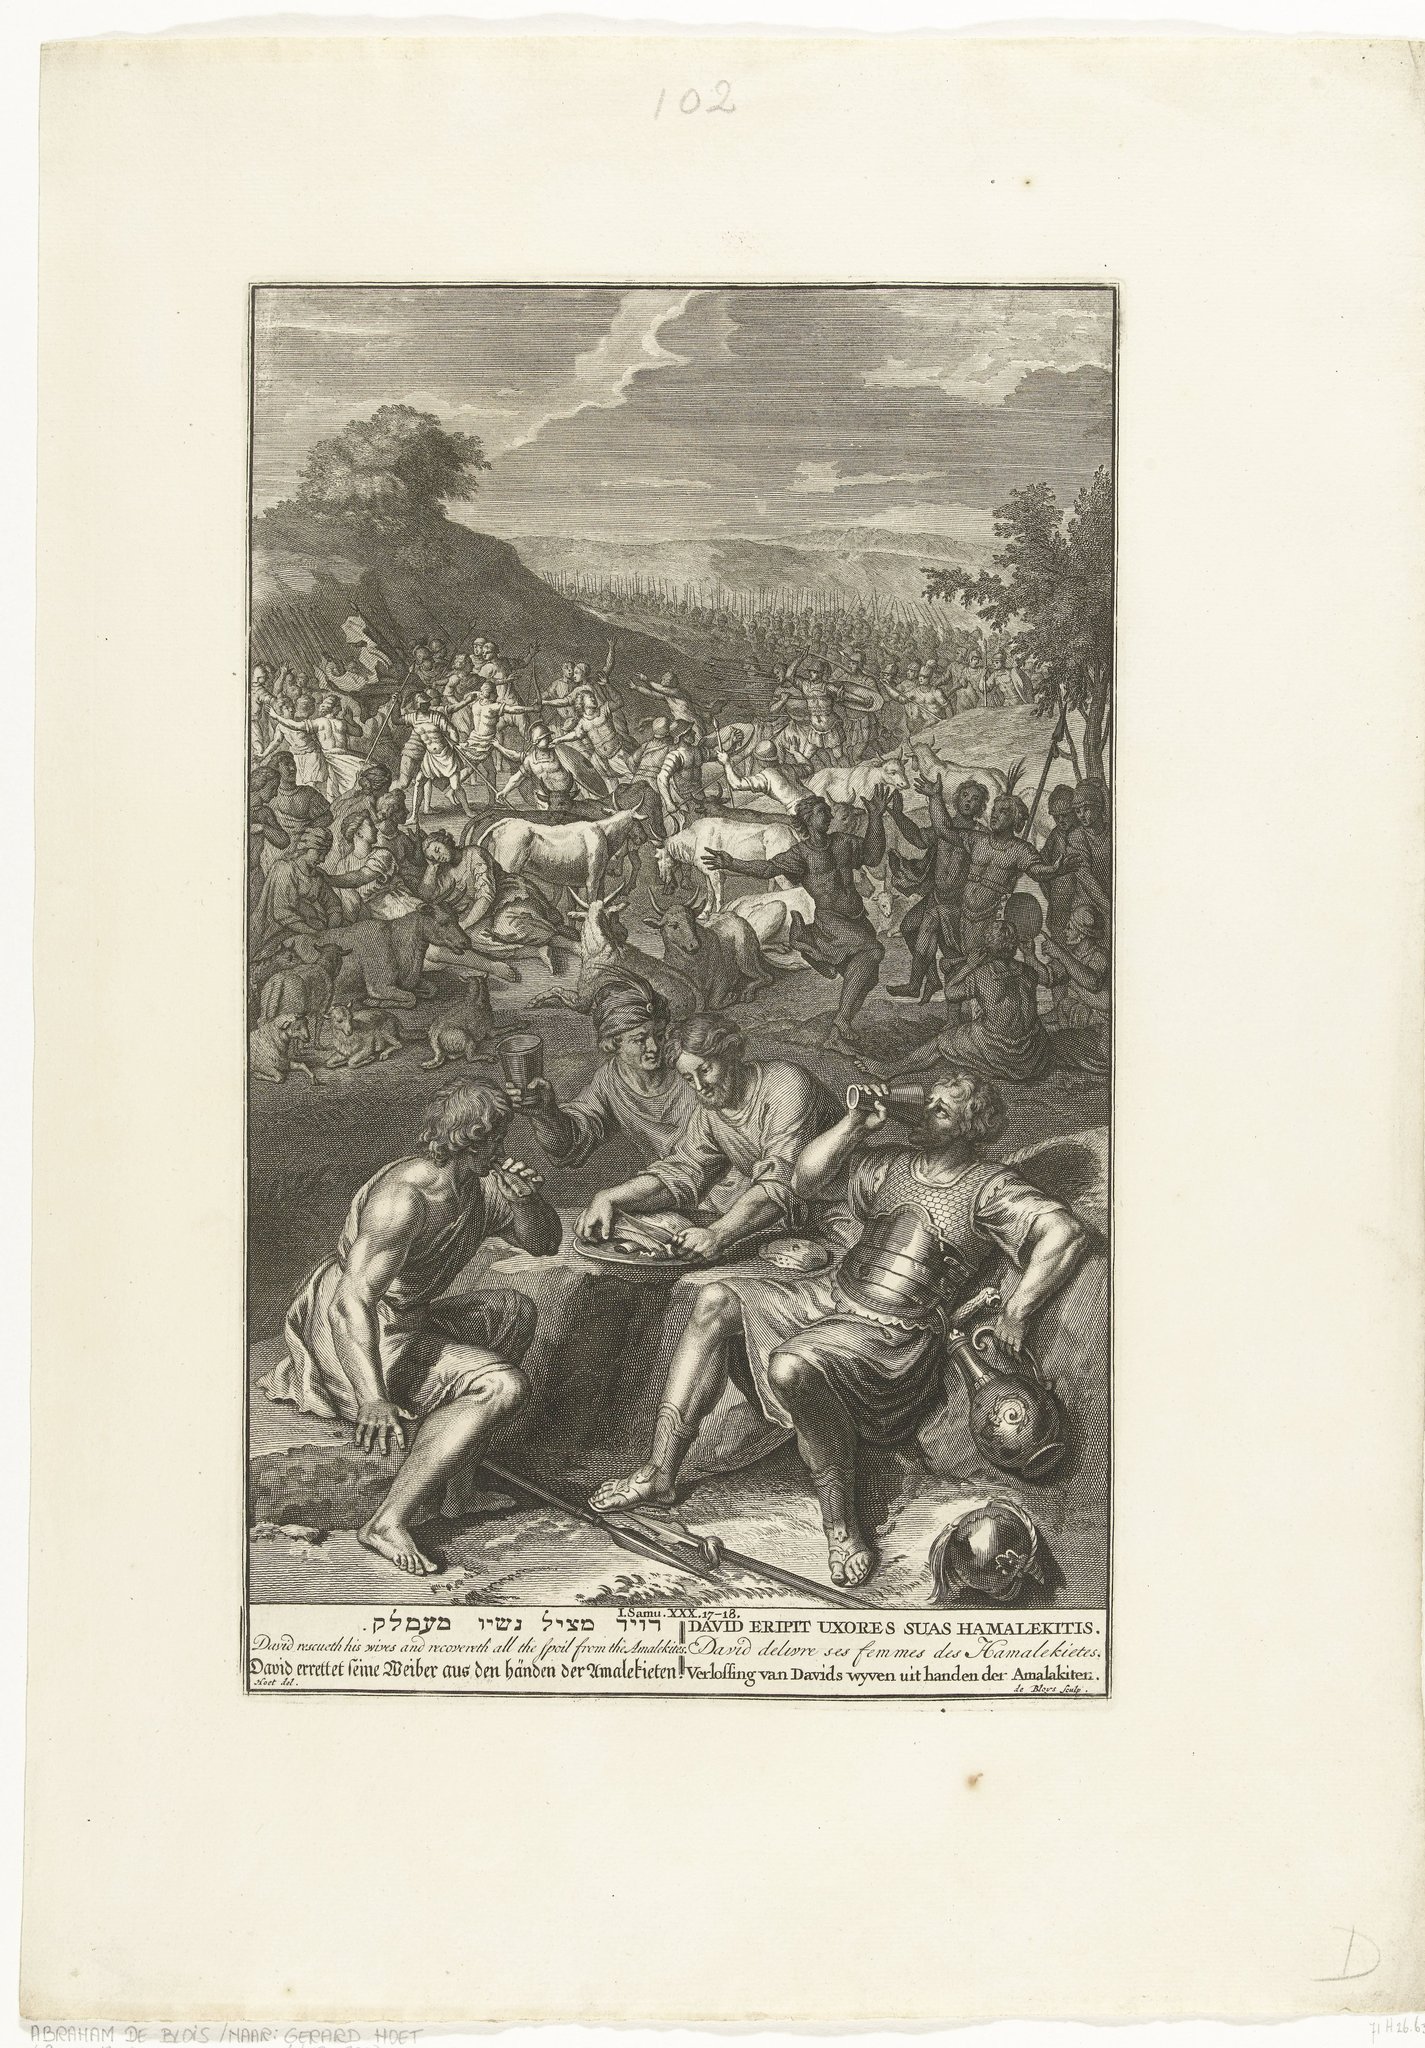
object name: book illustration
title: Verlossing van Davids wyven uit handen der Amalekiten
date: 1679-1717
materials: paper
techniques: engraving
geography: amsterdam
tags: david finds the amalekites feasting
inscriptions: collector's mark: Lugt 2228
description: De ontwerptekening van Gerard Hoet voor deze bijbelscène bevindt zich in de collectie van het Rijksmuseum Amsterdam, vergelijk inv.nr. RP-T-1886-A-671. Prent gemaakt voor: Figures de la Bible. Amsterdam, Bernard Picart, 1720. Prent ook gebruikt in: Taferelen der voornaamste geschiedenissen van het Oude en Nieuwe Testament [..] door de vermaarde kunstenaars Hoet, Houbraken, en Picart getekent [..] en met beschrijvingen uitgebreid. Den Haag: Pieter de Hondt, 1728.